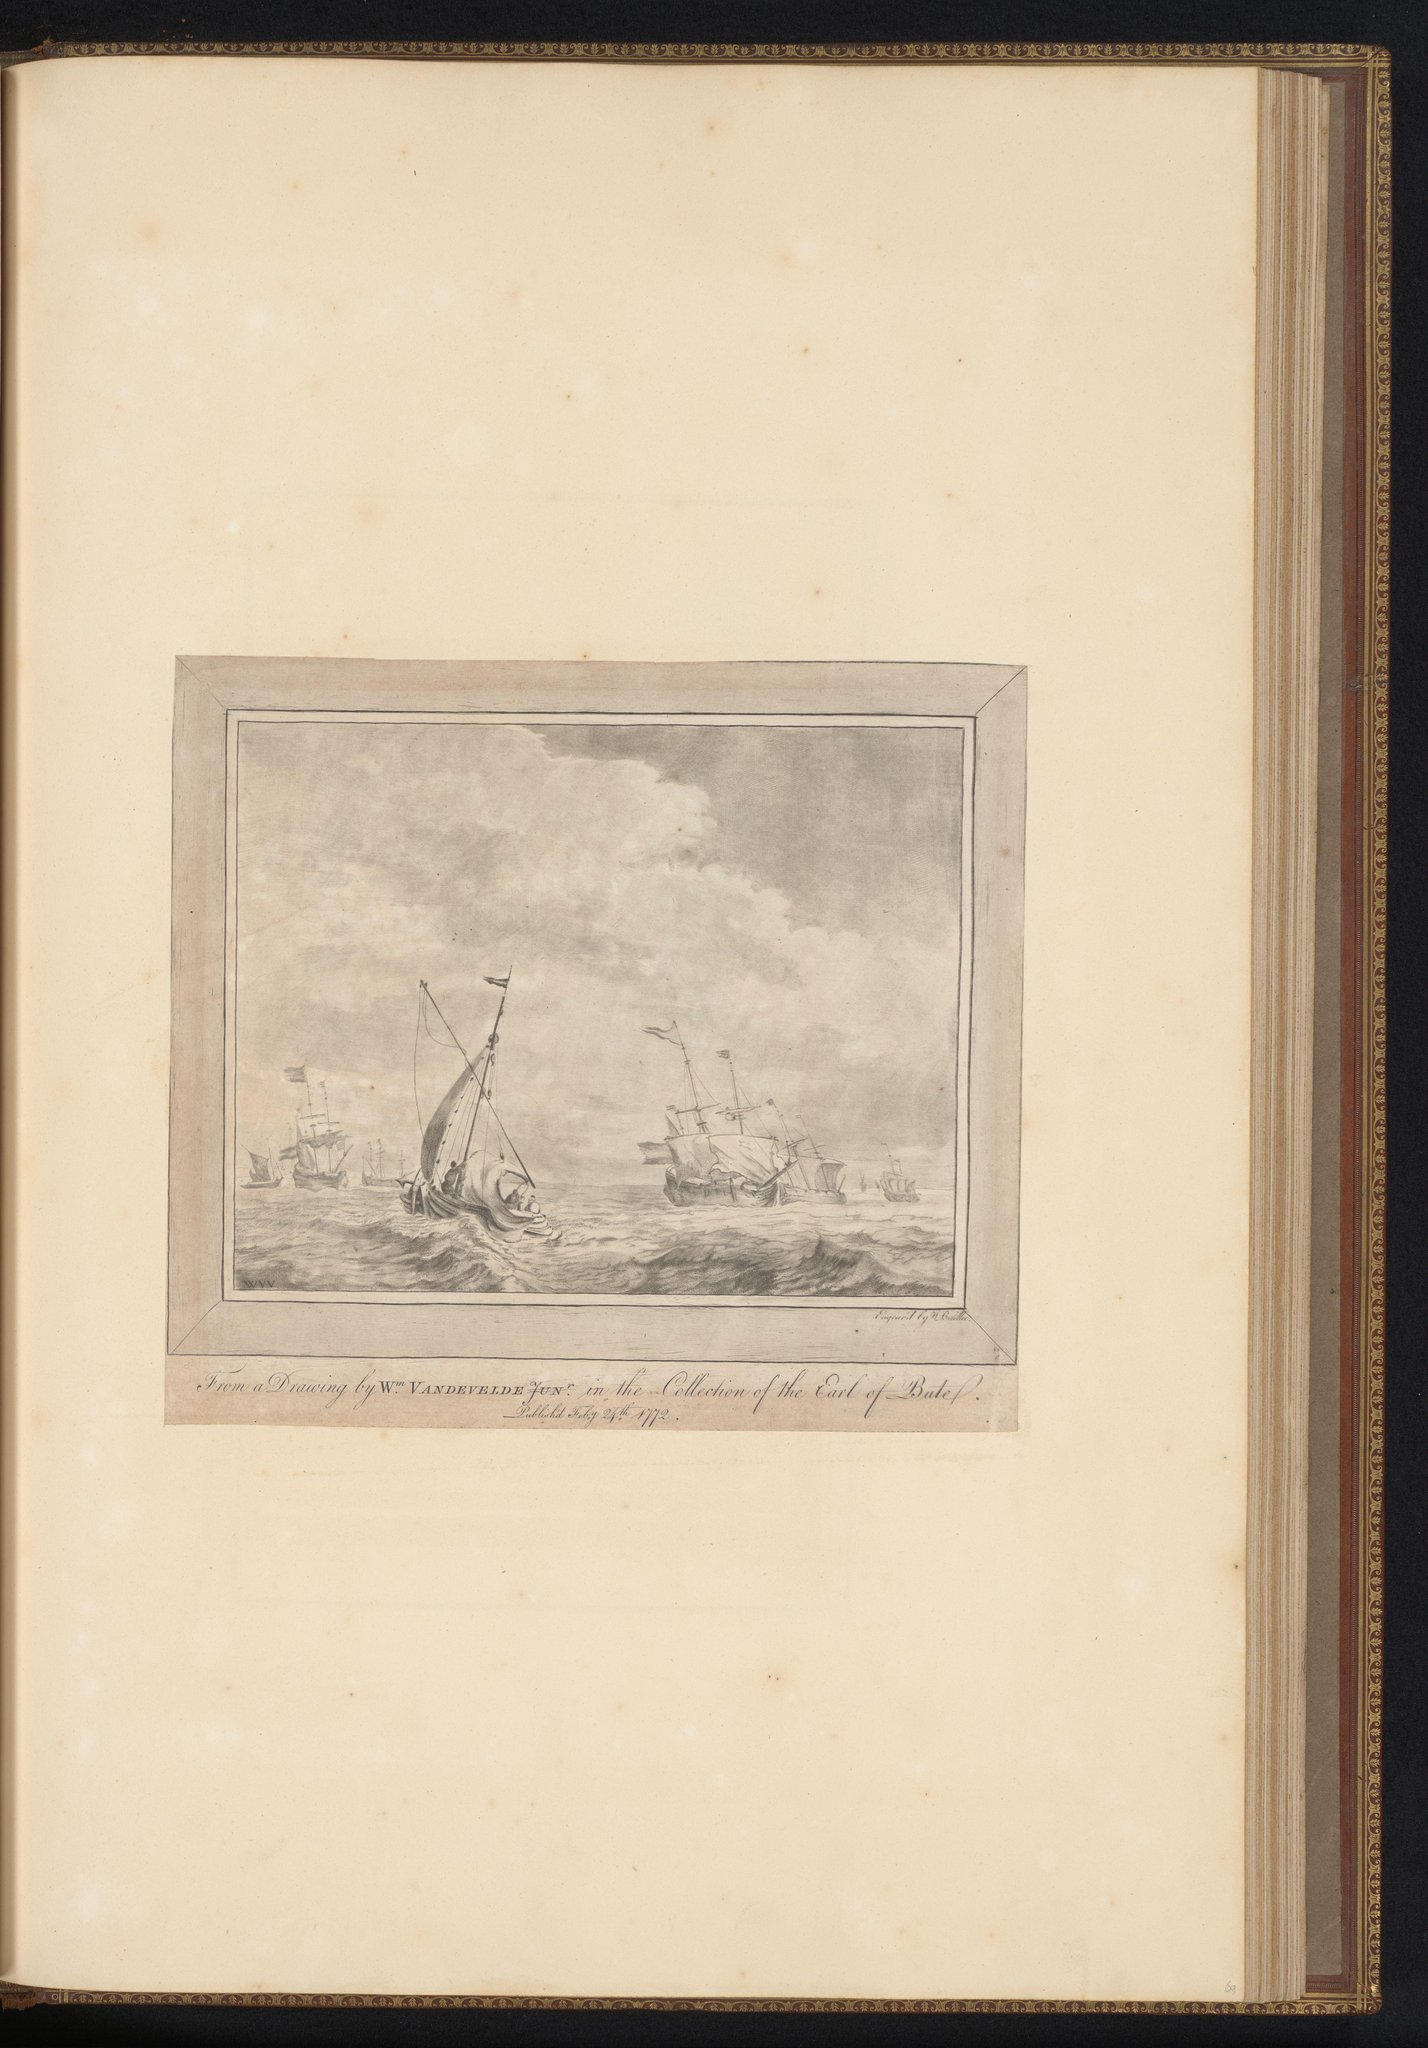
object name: album leaf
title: Schepen op een rustige zee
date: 1772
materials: paper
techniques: printmaking, rocker stamped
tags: sea (seascape), laundering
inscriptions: date